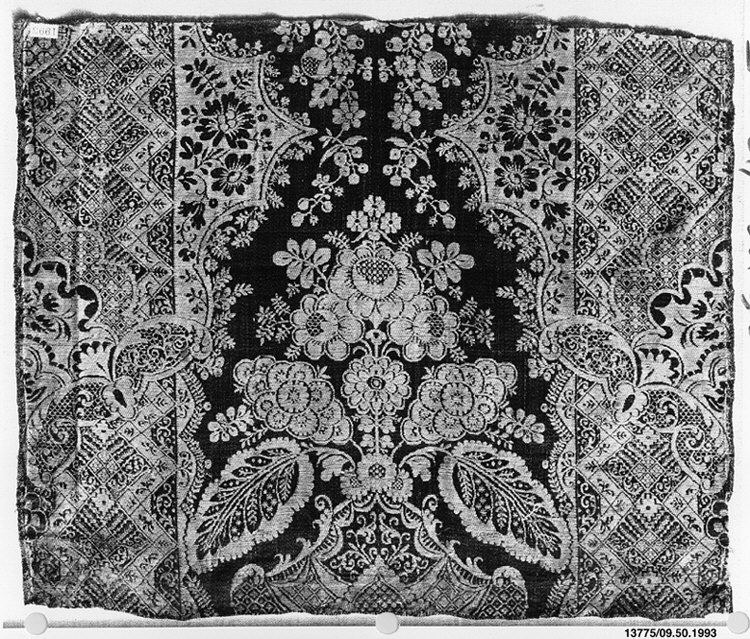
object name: piece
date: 1720-1724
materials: linen, silk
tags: flowers,leaves